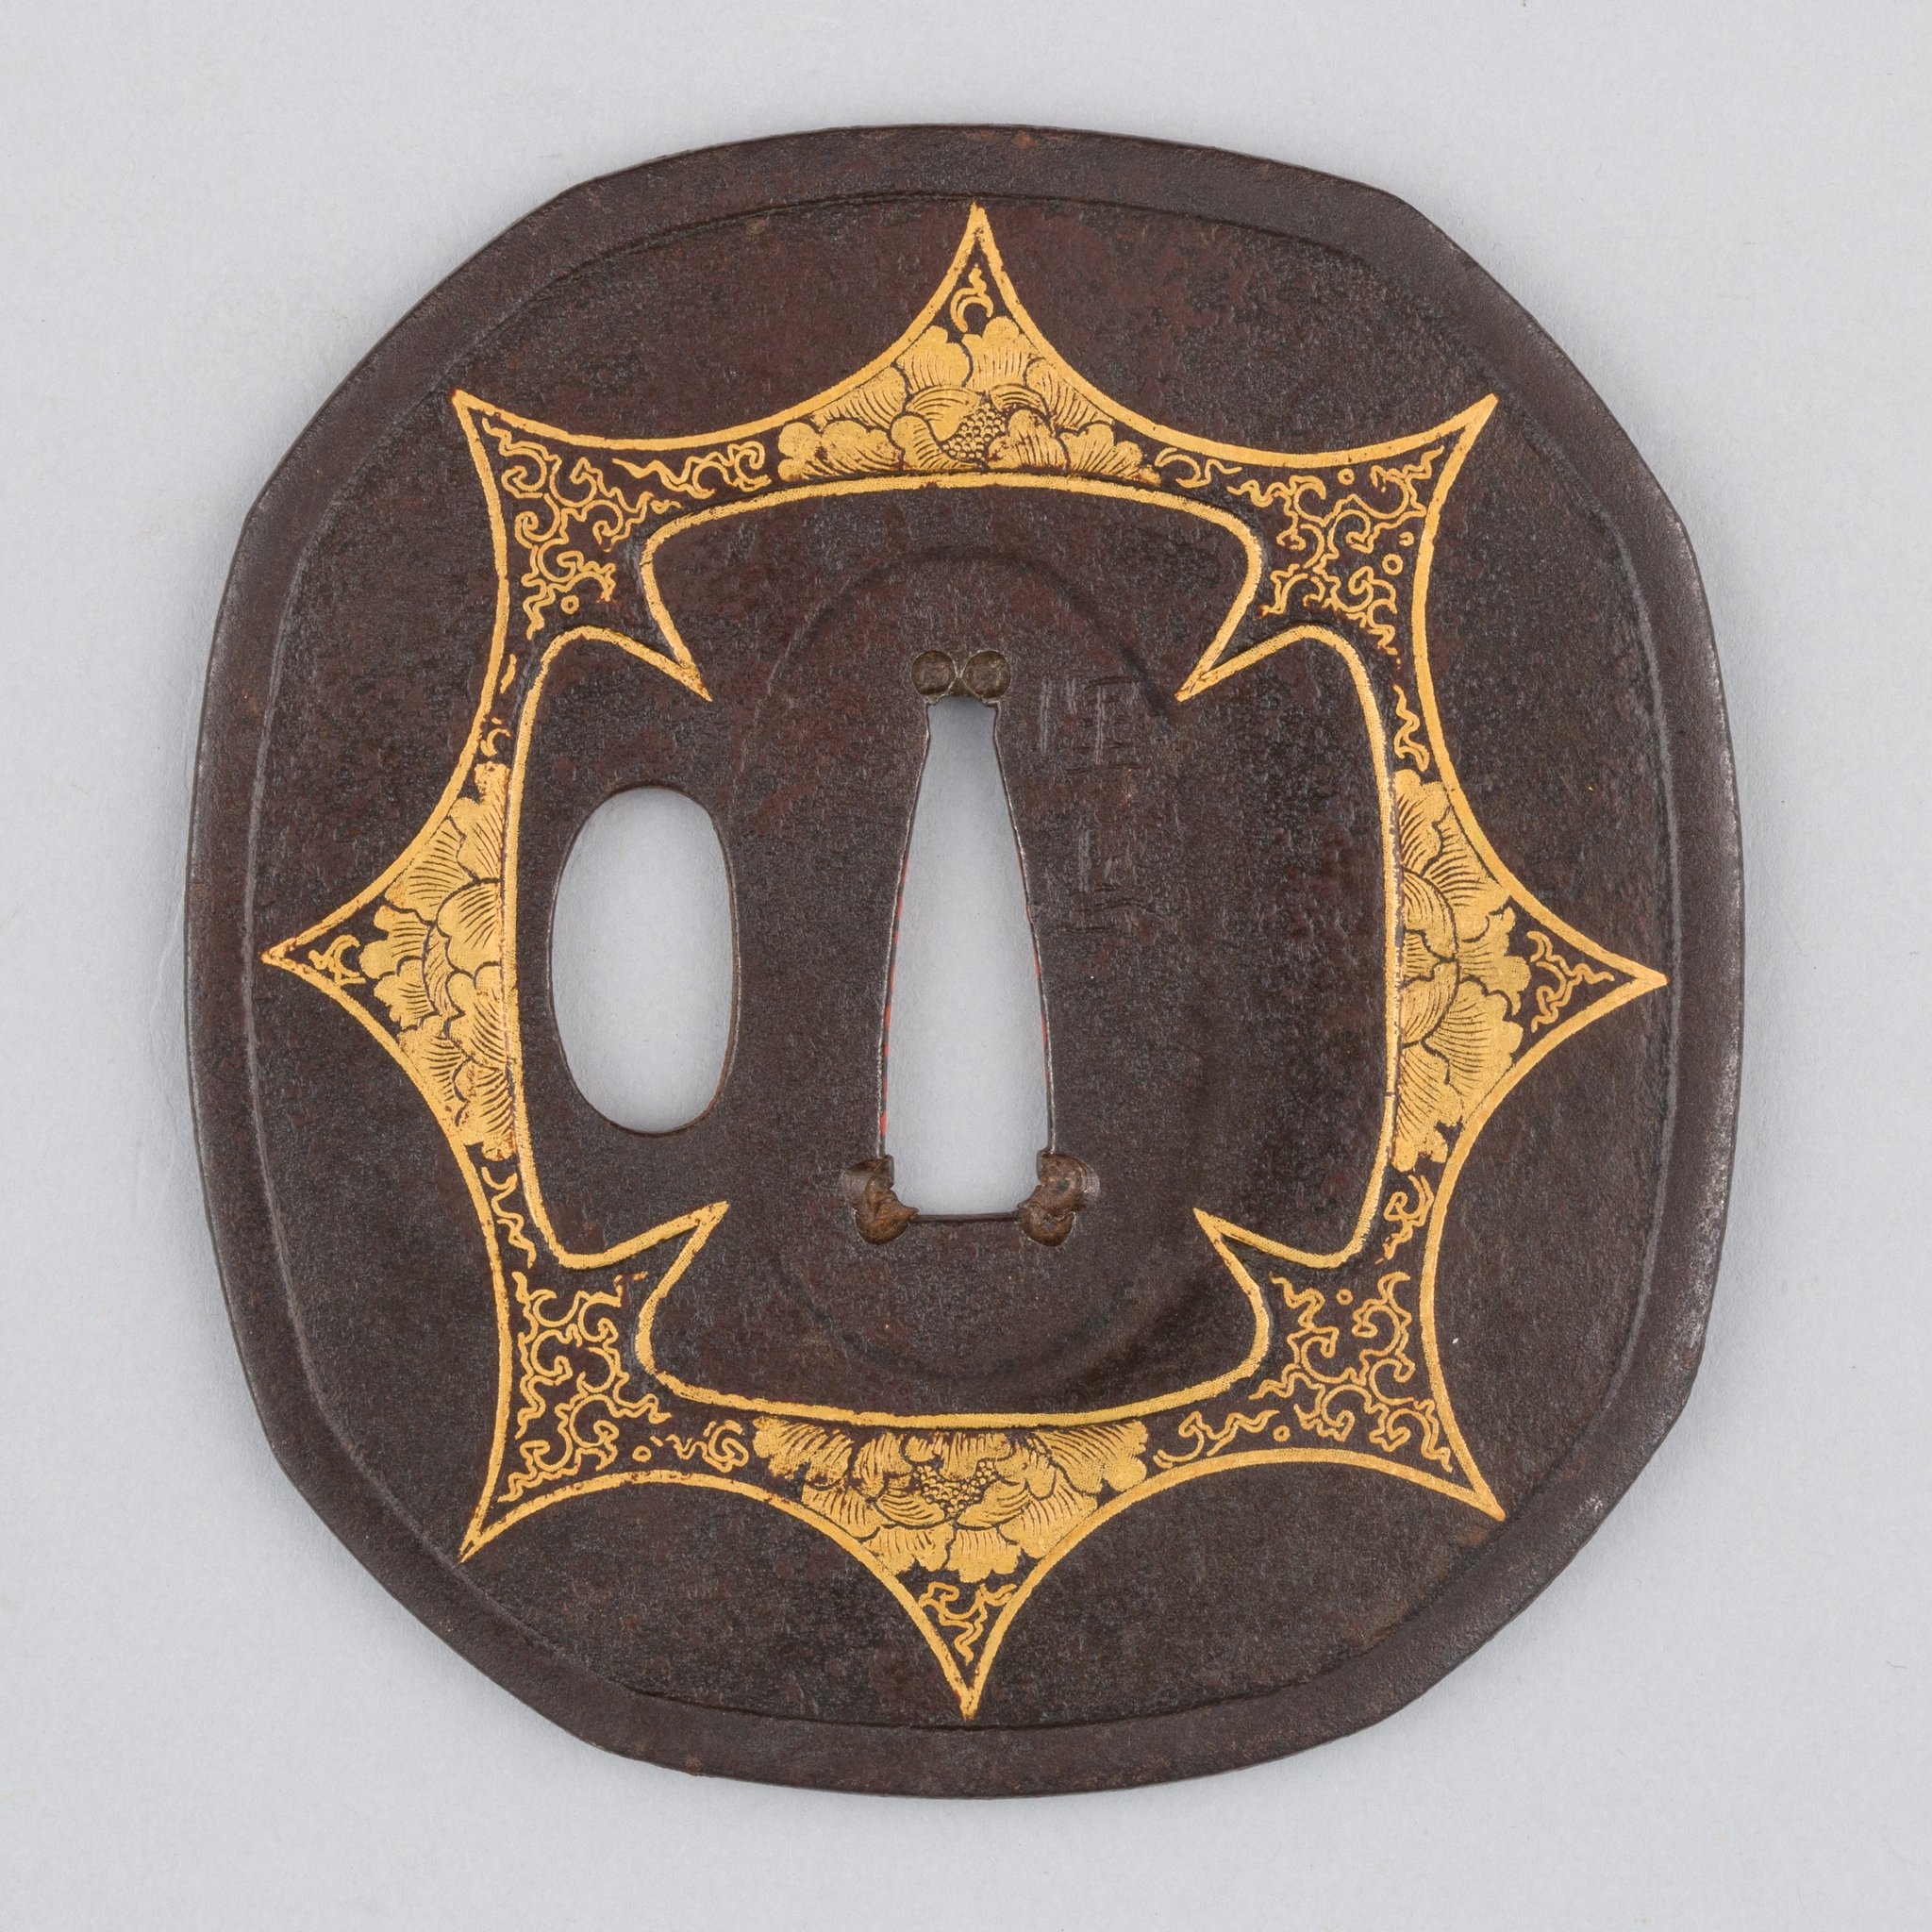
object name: sword guard tsuba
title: Sword Guard (Tsuba)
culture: japanese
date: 1601-1700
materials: copper, gold, iron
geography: japan